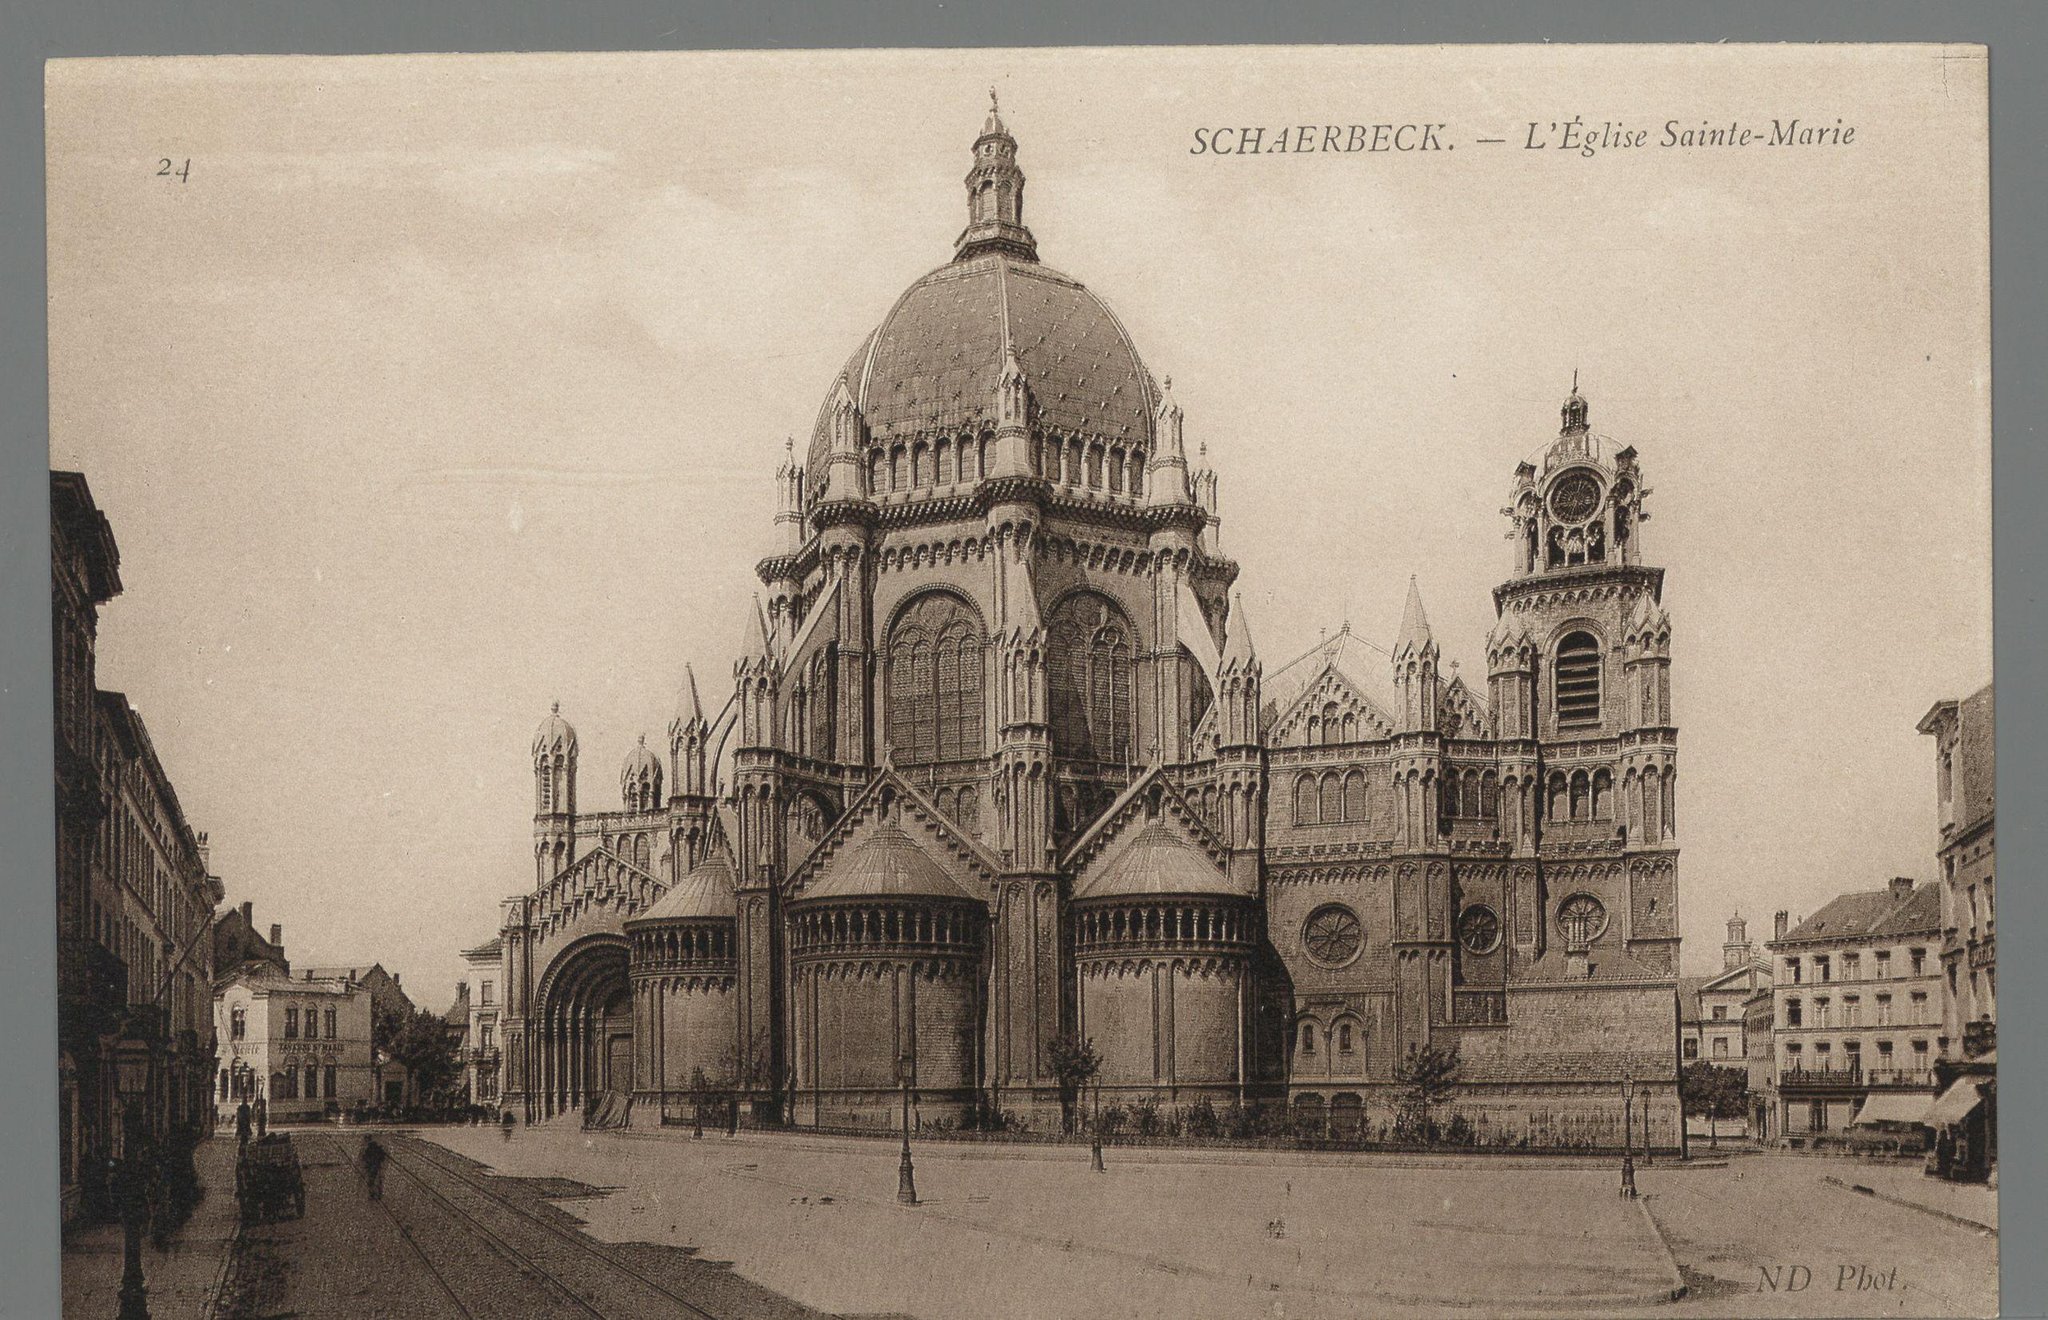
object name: photomechanical print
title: Schaerbeck. L'Église Sainte-Marie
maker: Anonymous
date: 1906-1918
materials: cardboard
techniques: photograph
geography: schaarbeek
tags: city-view, and landscape with man-made constructions, church (exterior)